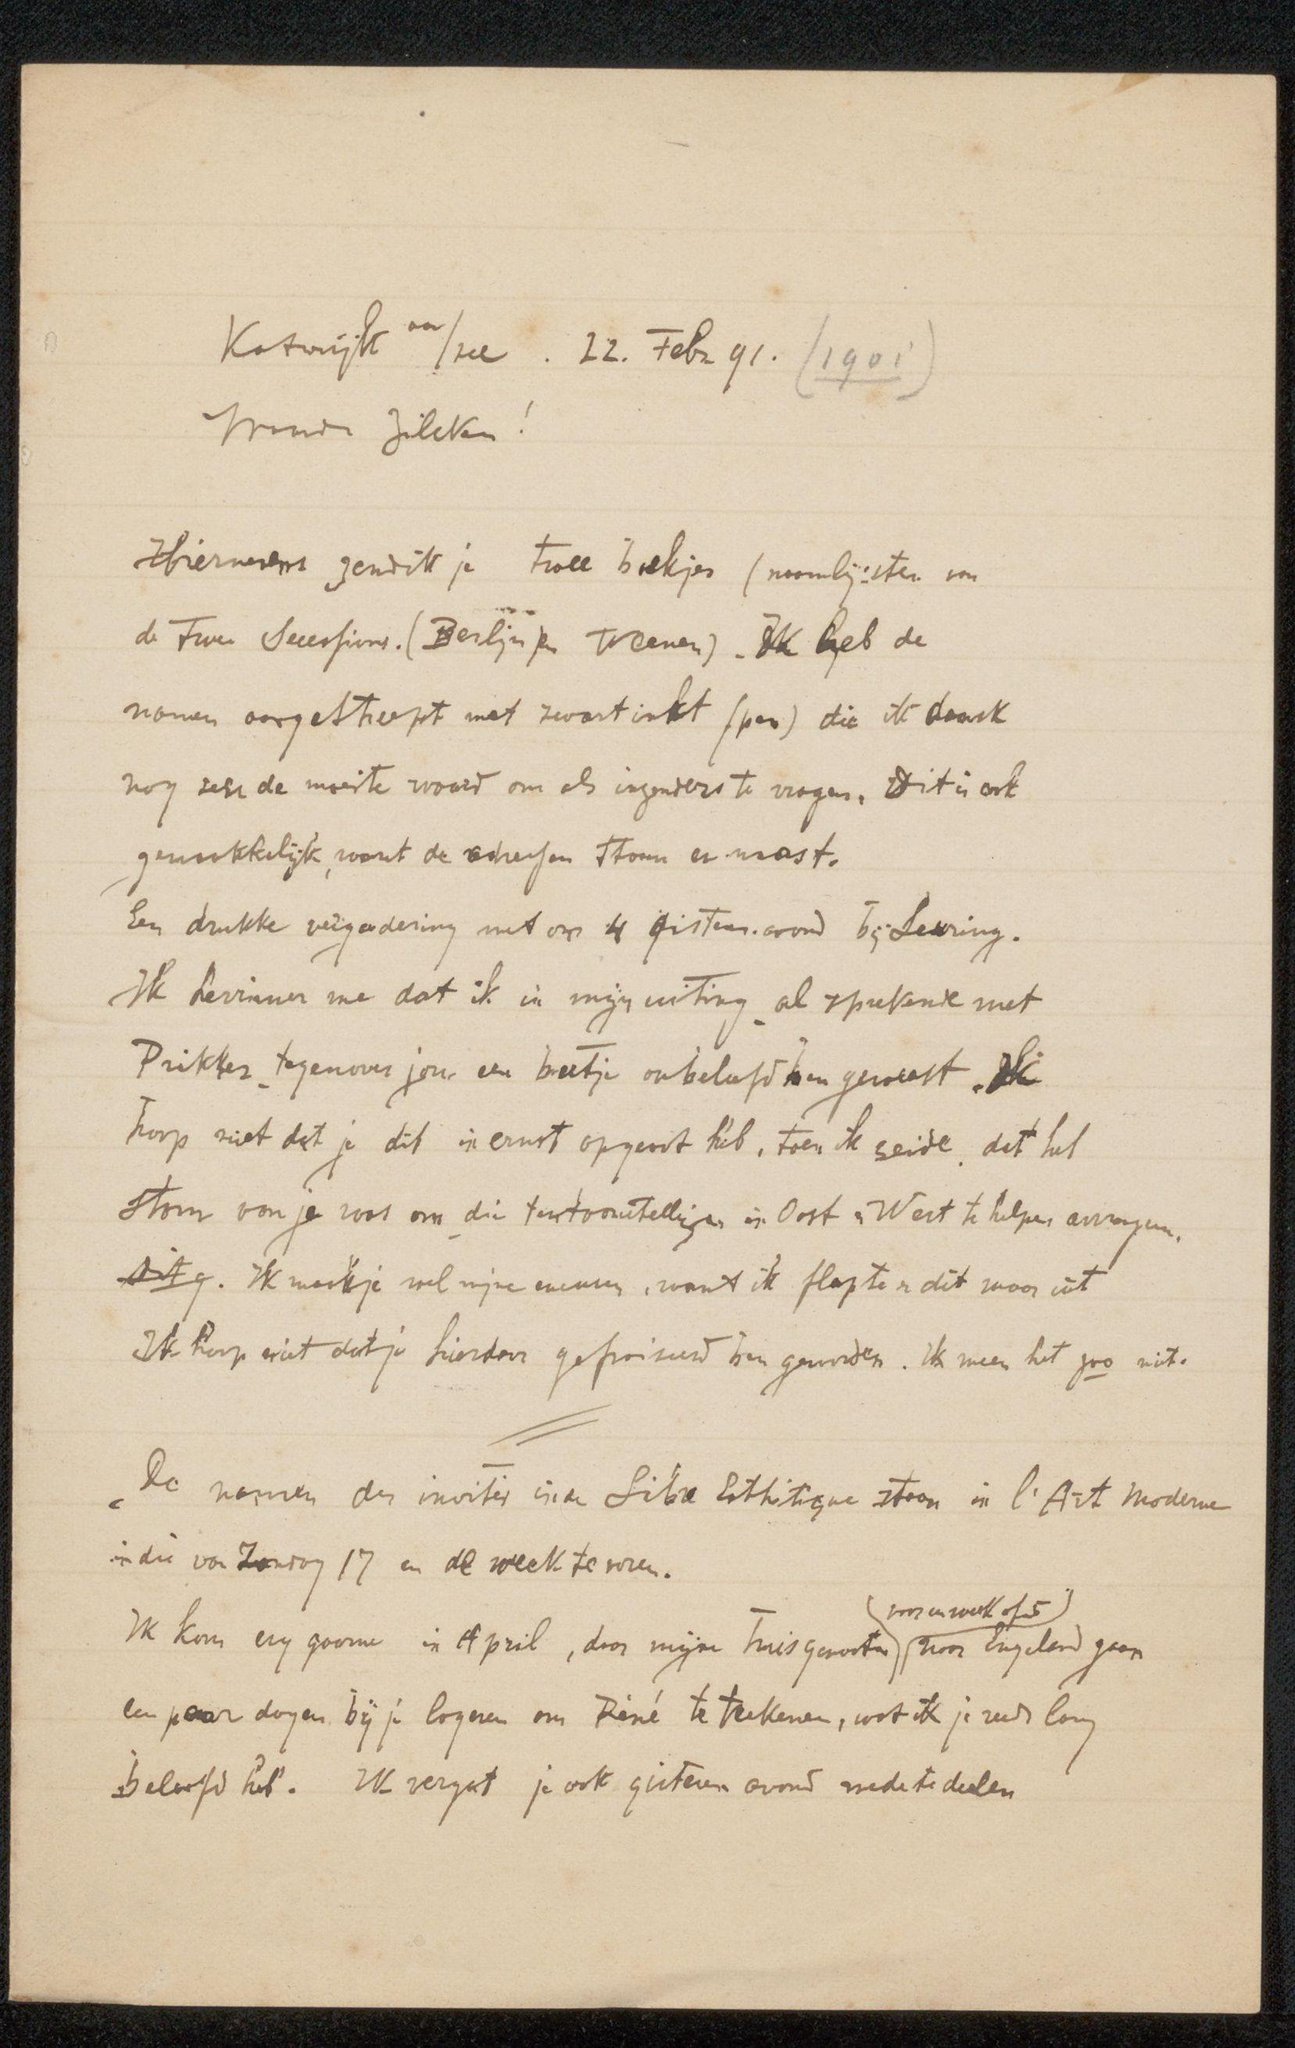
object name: letter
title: Brief aan Philip Zilcken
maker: jan toorop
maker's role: draughtsman, painter, print maker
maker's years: 1858-1928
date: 1901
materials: ink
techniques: pen, writing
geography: katwijk aan zee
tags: hendrik willem mesdag, den bosch, amsterdam, antoon derkinderen, the hague, painter, print maker, draughtsman, theo van hoytema, rotterdam, simon moulijn, cologne, johan thorn prikker, voorburg, renée hélène laure zilcken, hendrik petrus berlage, willem leuring, philip zilcken, exhibition ~ art, historical persons (portraits and scenes from the life), england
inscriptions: collector's mark: ‘RPK’